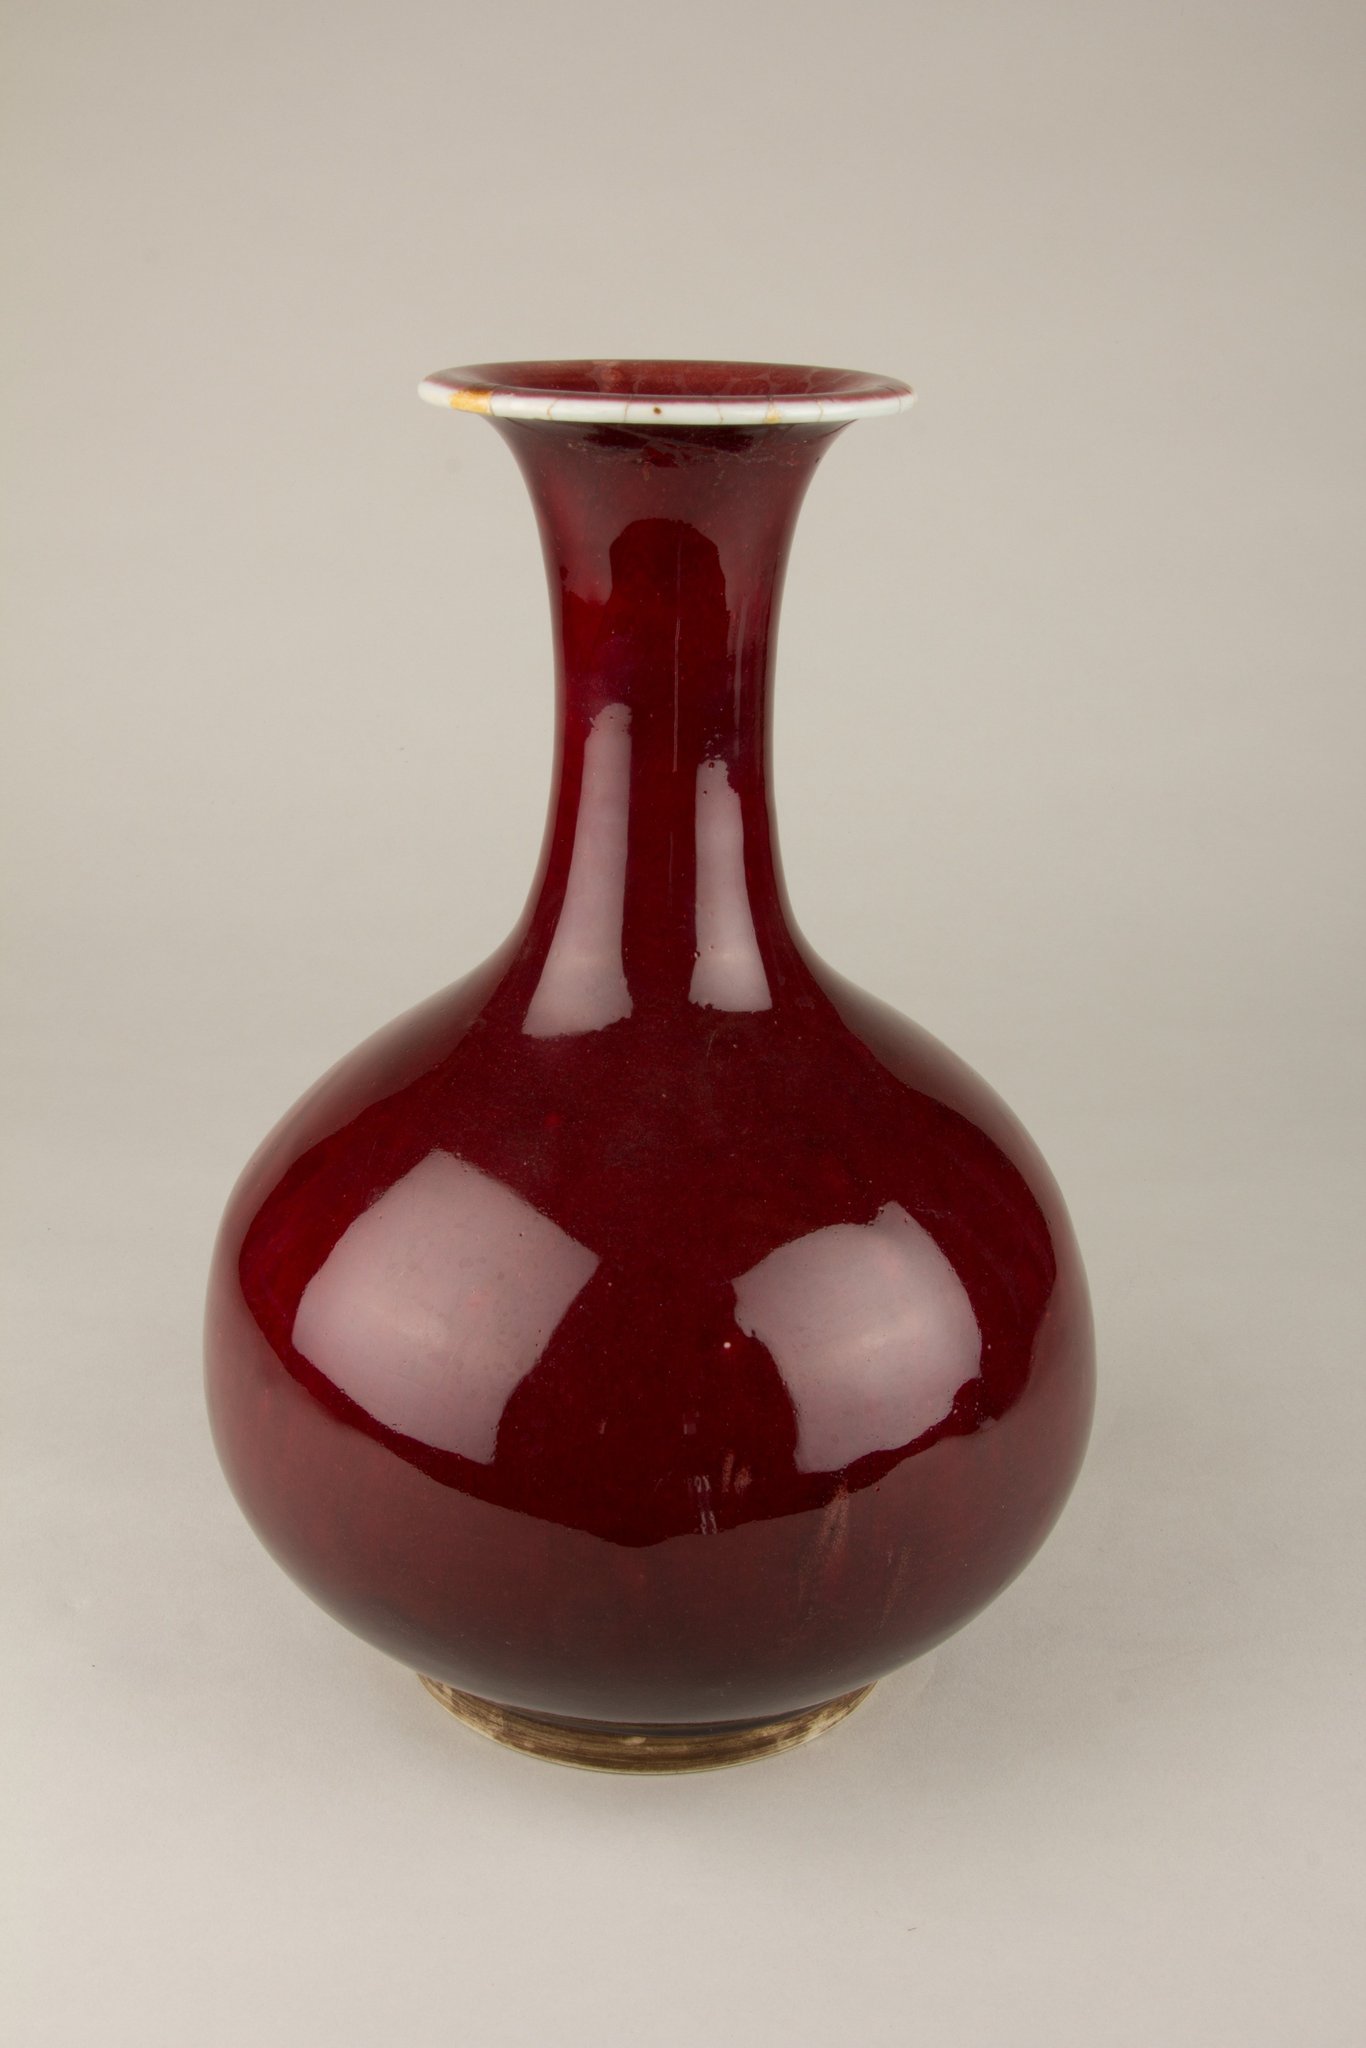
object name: vase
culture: chinese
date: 1662-1722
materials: porcelain